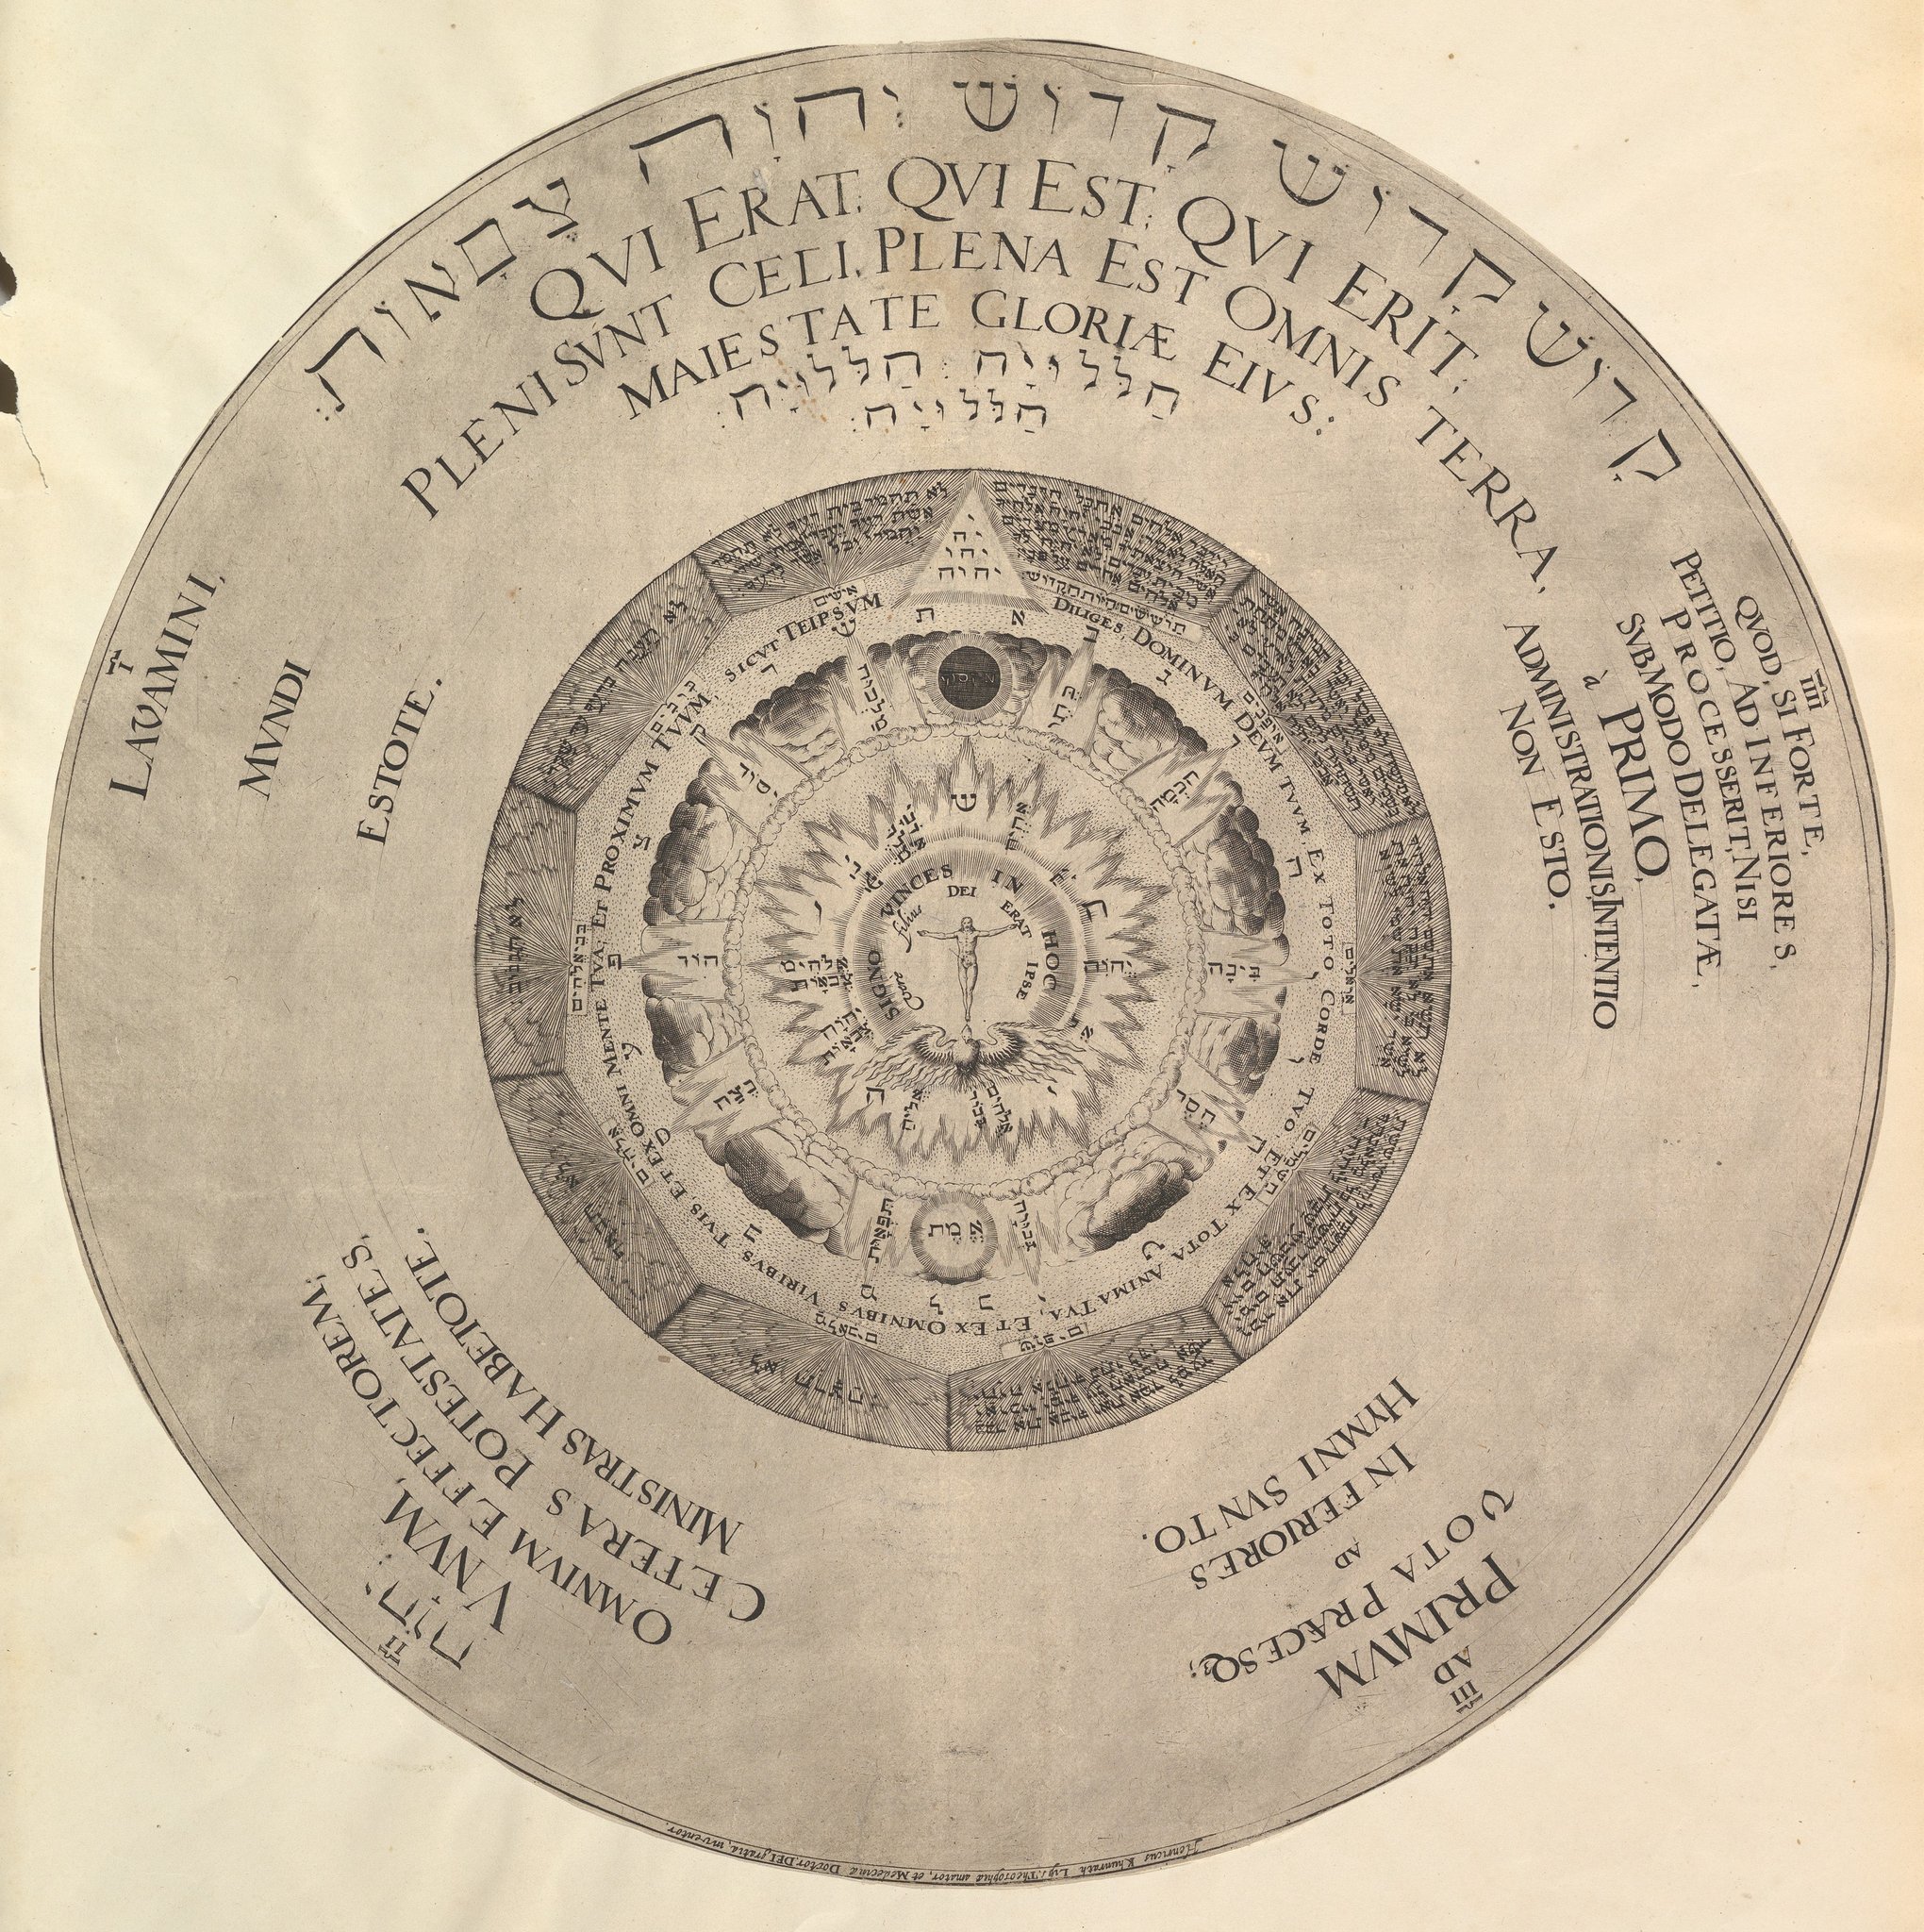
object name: print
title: Scheme of Christian Kabbalism from Heinrich Khunrath, Amphiteatrum sapientiae aeternae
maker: peter van der doort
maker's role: artist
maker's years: 1590-1605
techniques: engraving